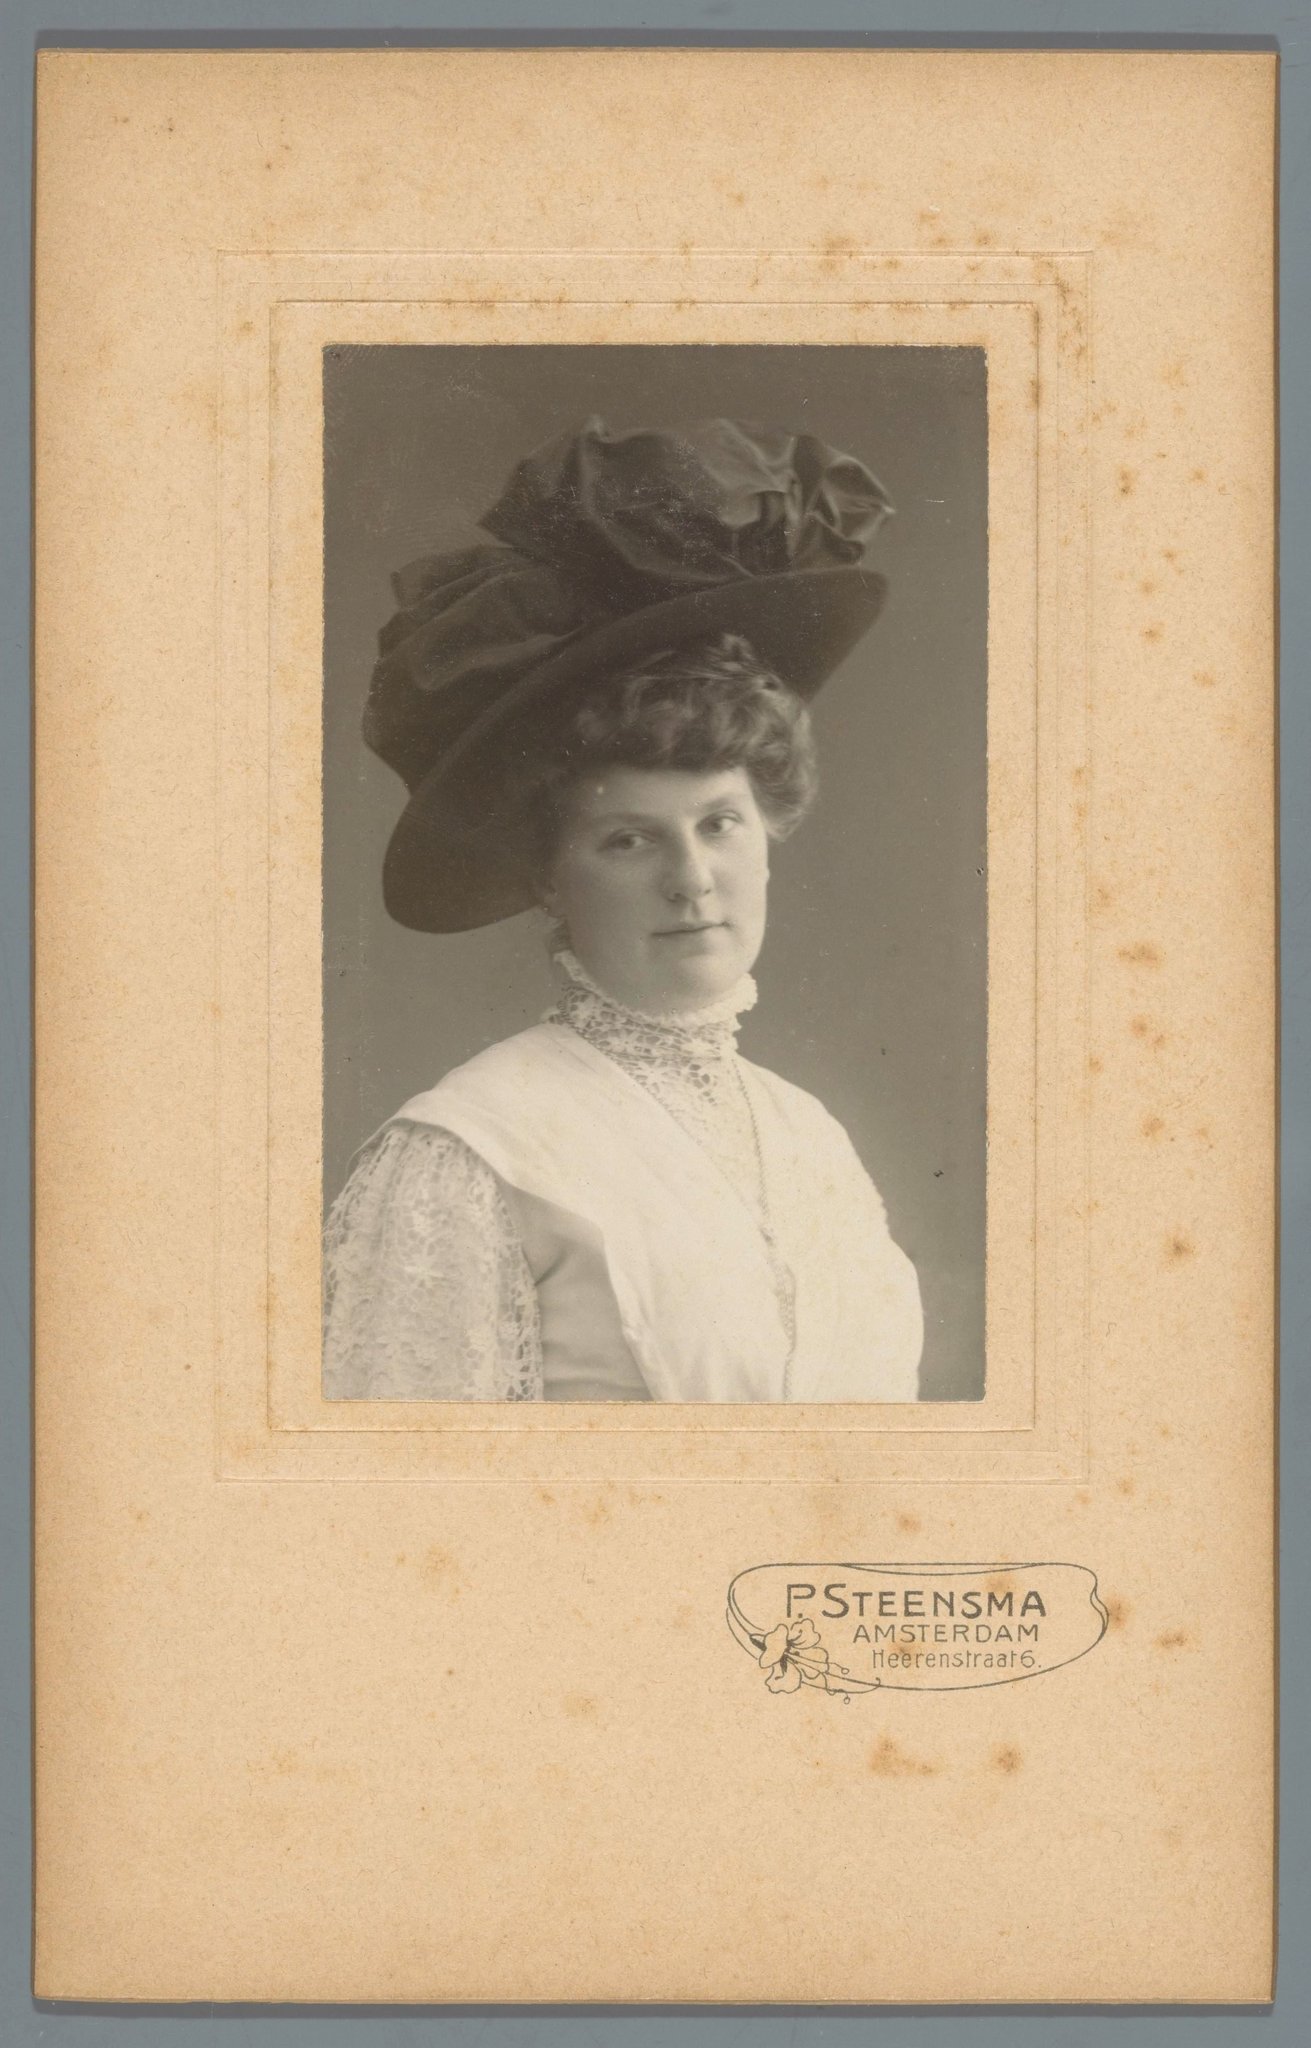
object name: photograph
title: Portret van een onbekende vrouw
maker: pier steensma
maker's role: fotograaf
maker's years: 1879-1931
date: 1910-1920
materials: cardboard, photographic support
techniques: gelatin silver print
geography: amsterdam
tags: adult woman